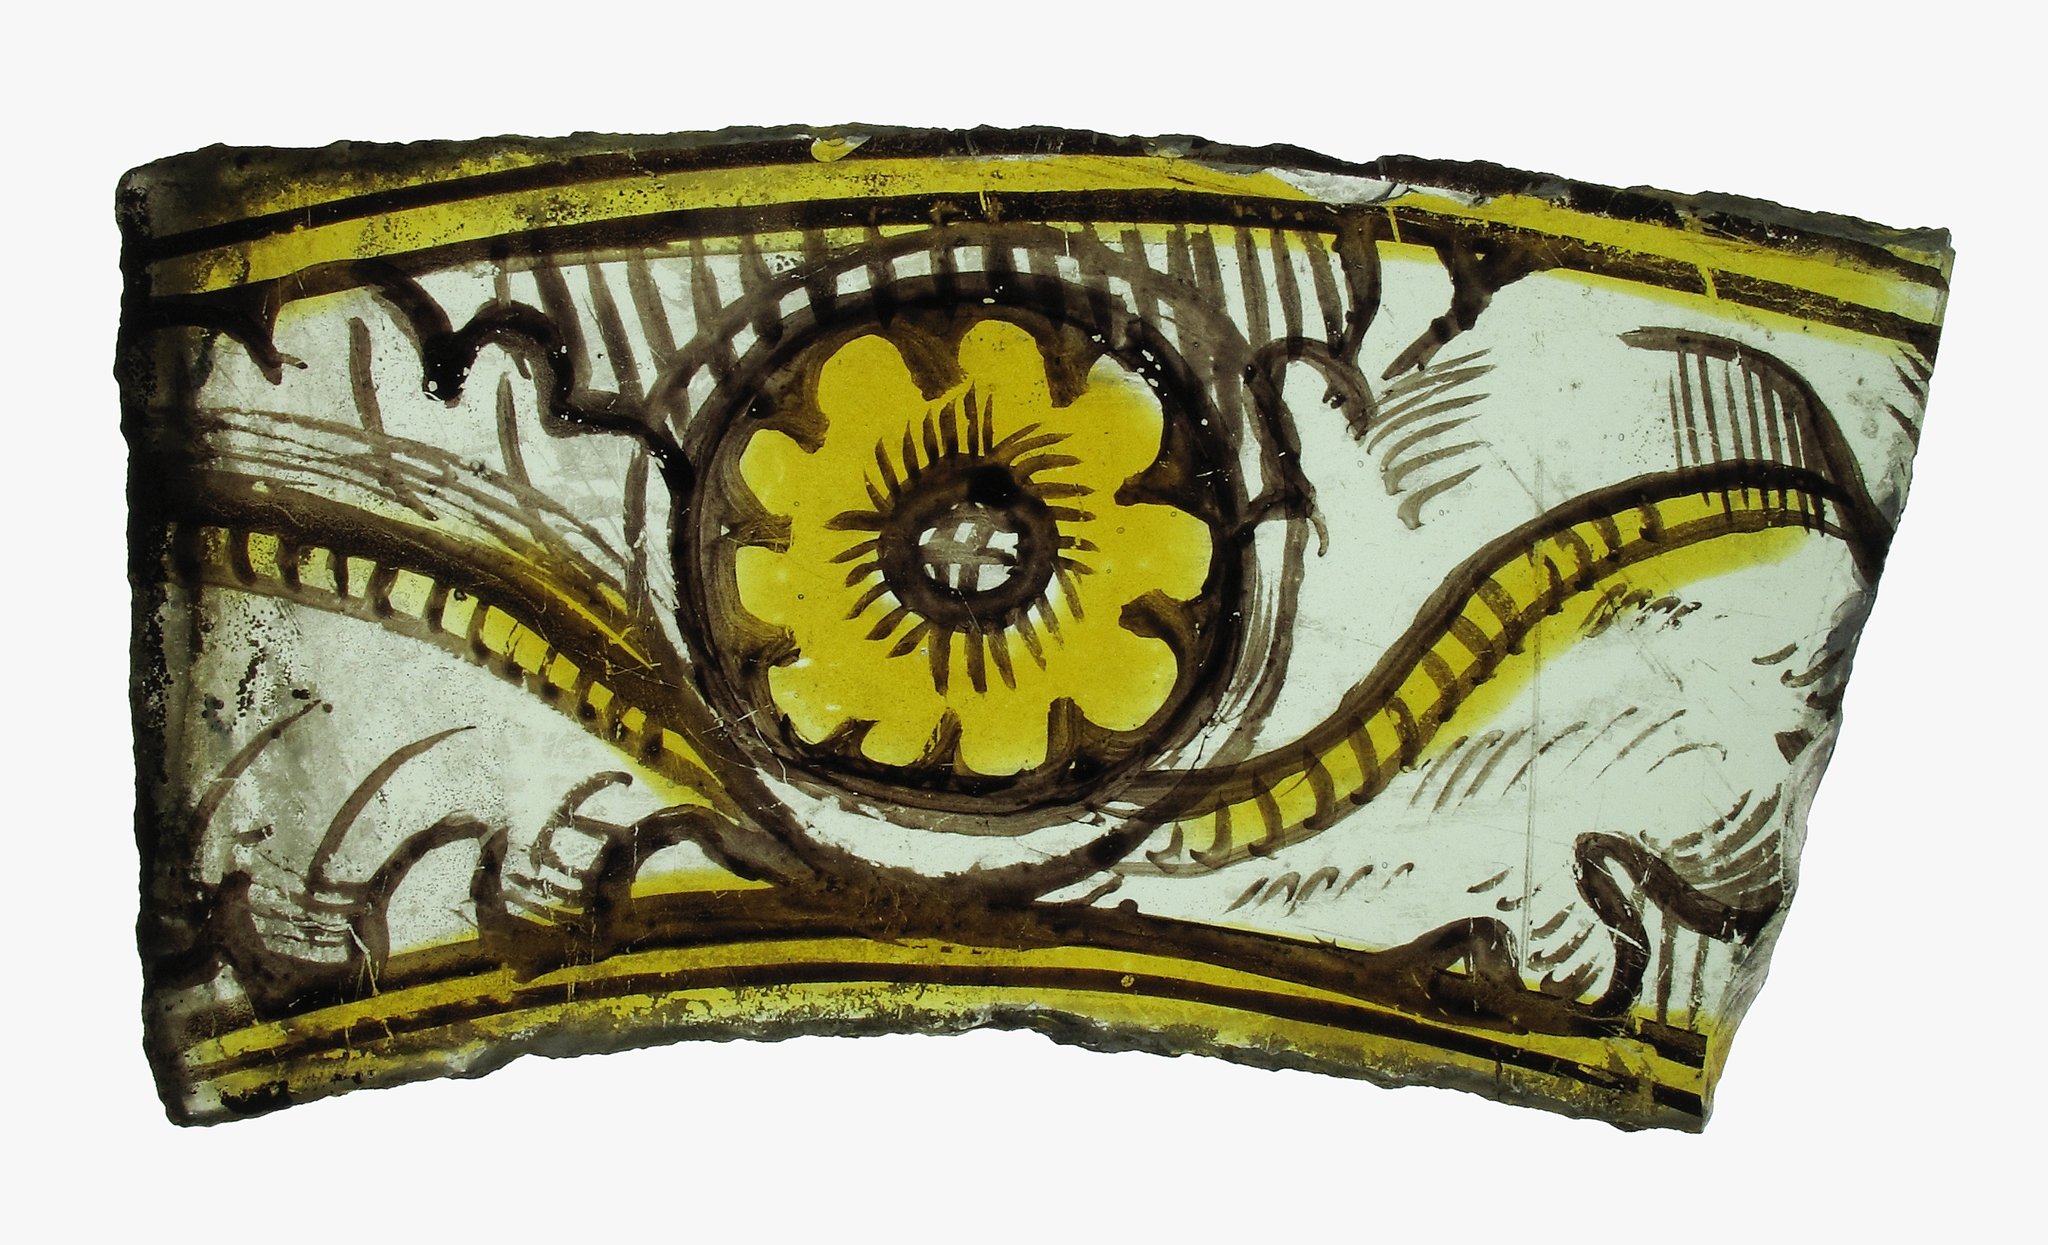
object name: fragment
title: Glass Fragment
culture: european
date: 1467-1500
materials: glass